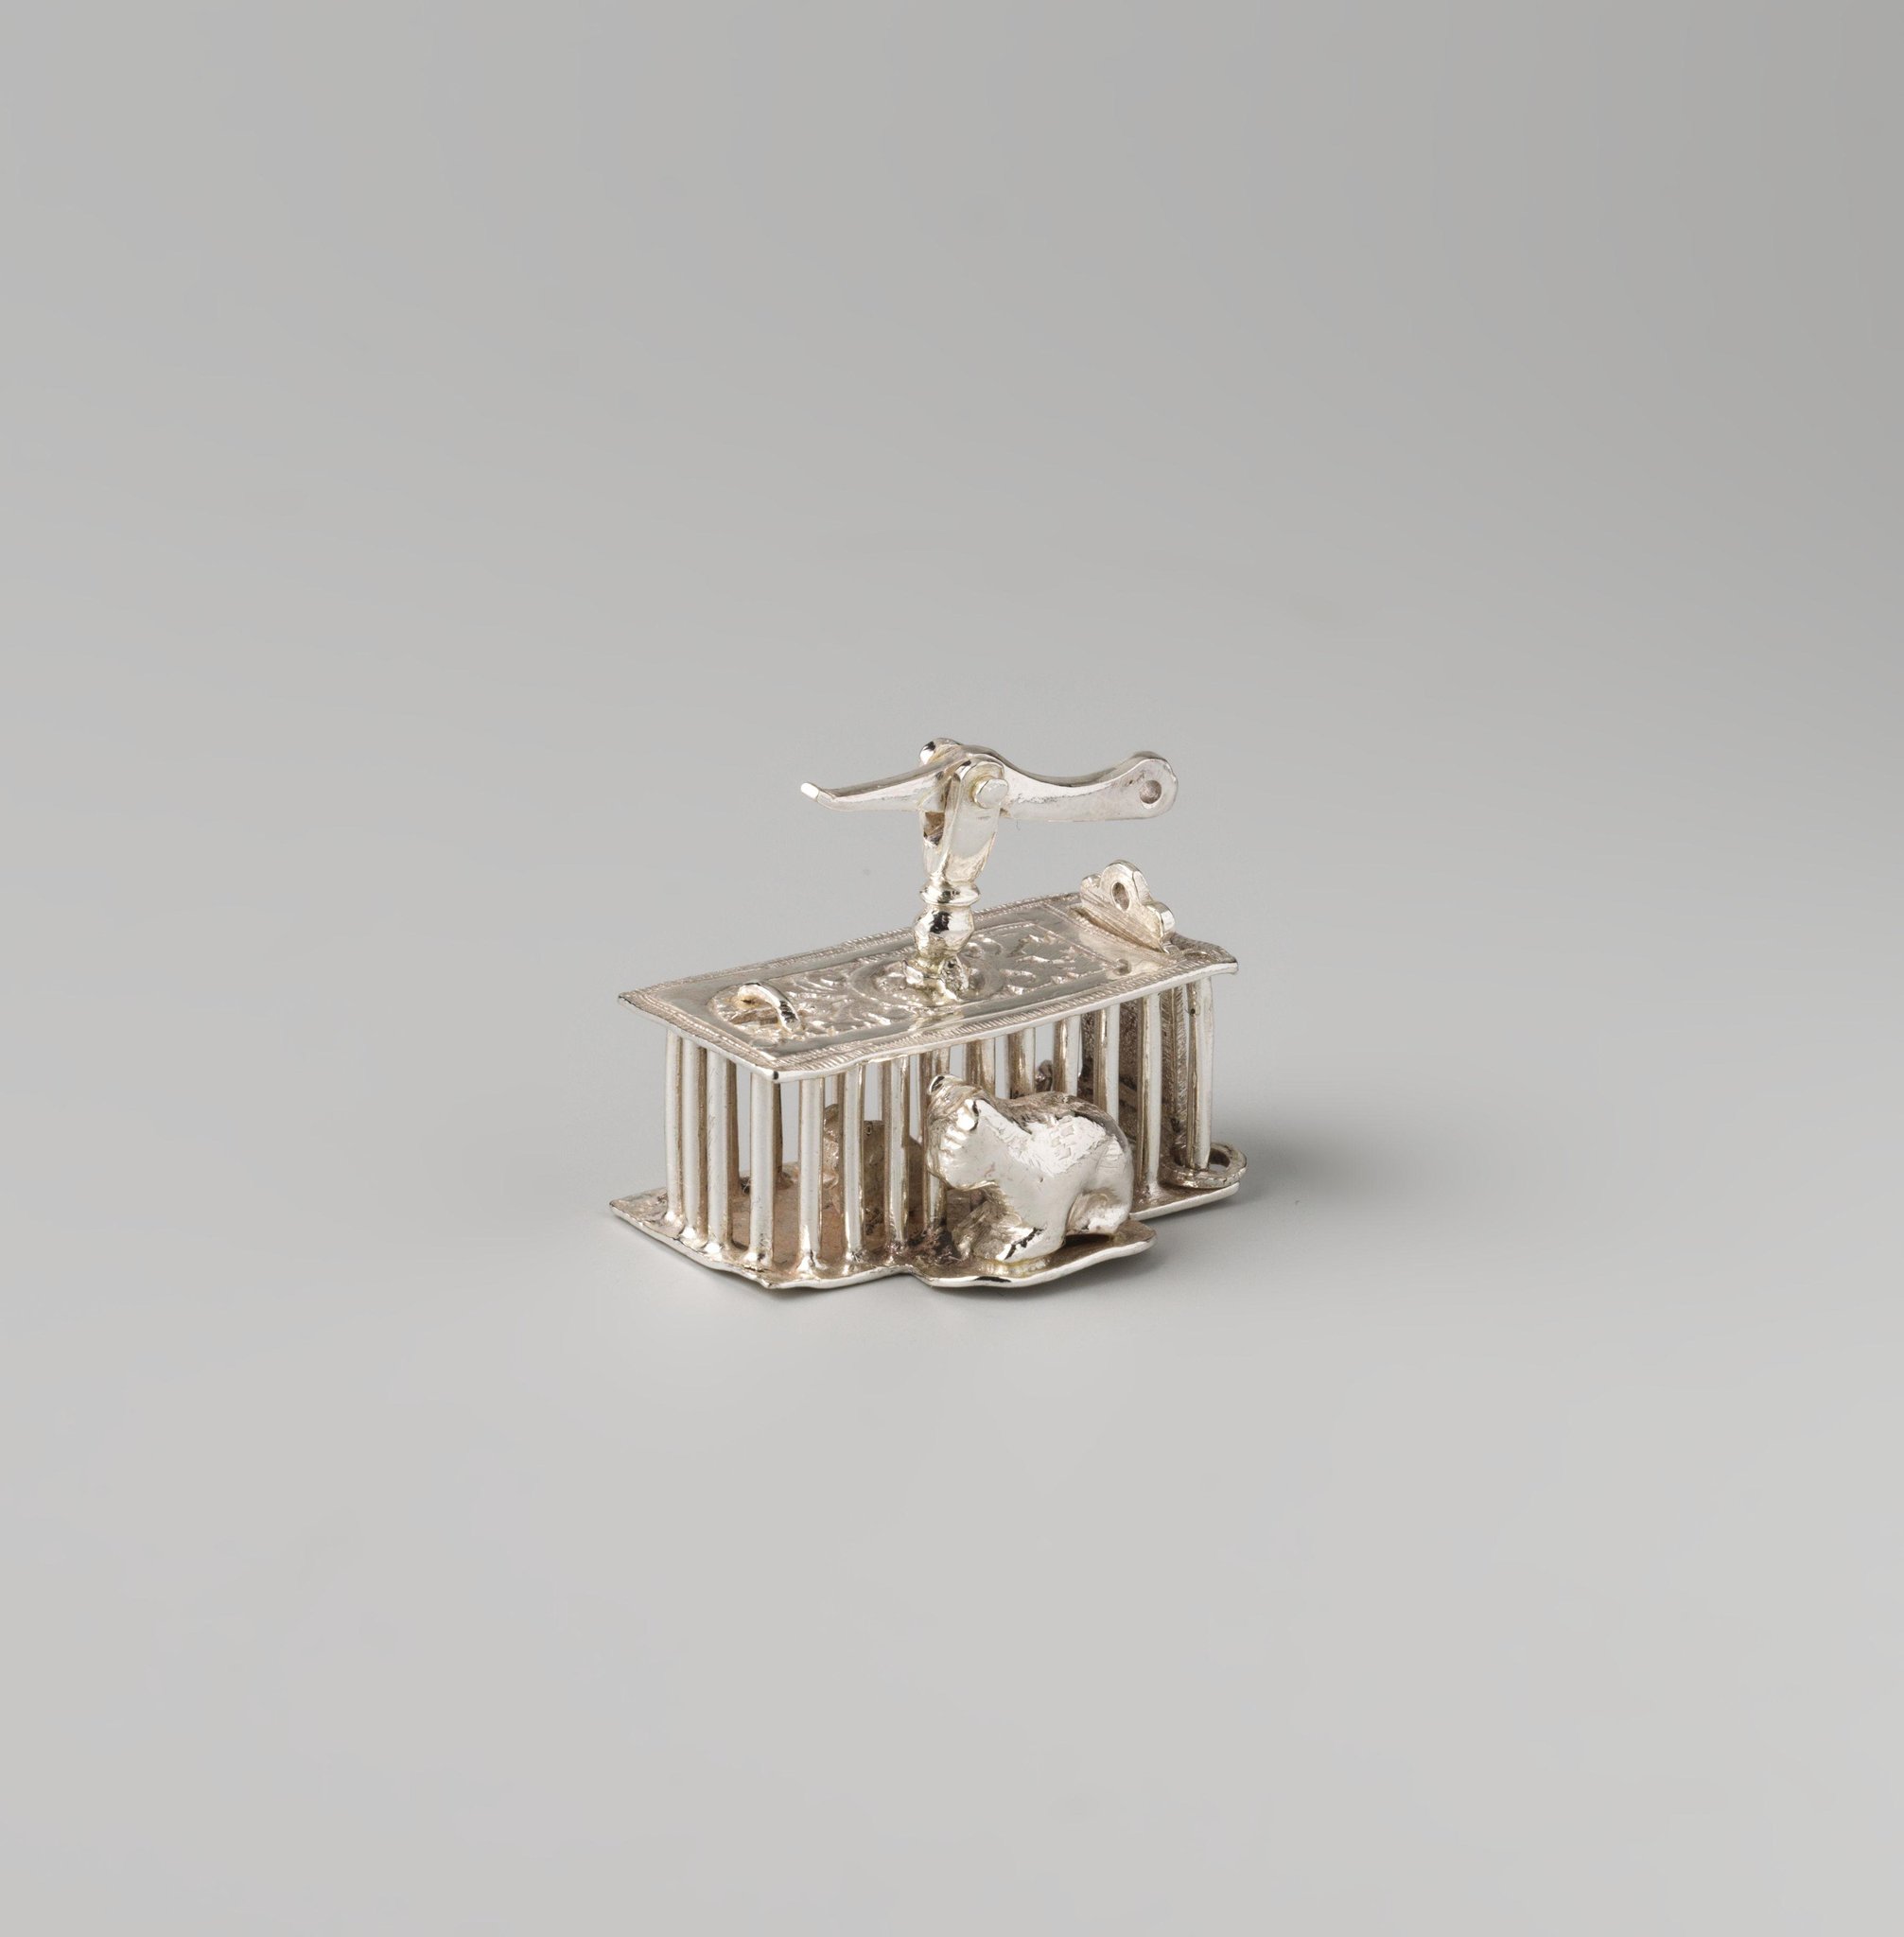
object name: mousetrap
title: Muizenval met kat van zilver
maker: wessel jansen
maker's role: silversmith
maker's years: -1696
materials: silver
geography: amsterdam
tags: cat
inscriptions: maker's mark: ‘W (Citroen 1975, nr. 903)’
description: Muizenval met kat van zilver, rechthoekig met spijlen en beweegbaar valluik. Het dak met bloemversieringen en trembleerrand. In de val een muis, naast de val een kat.